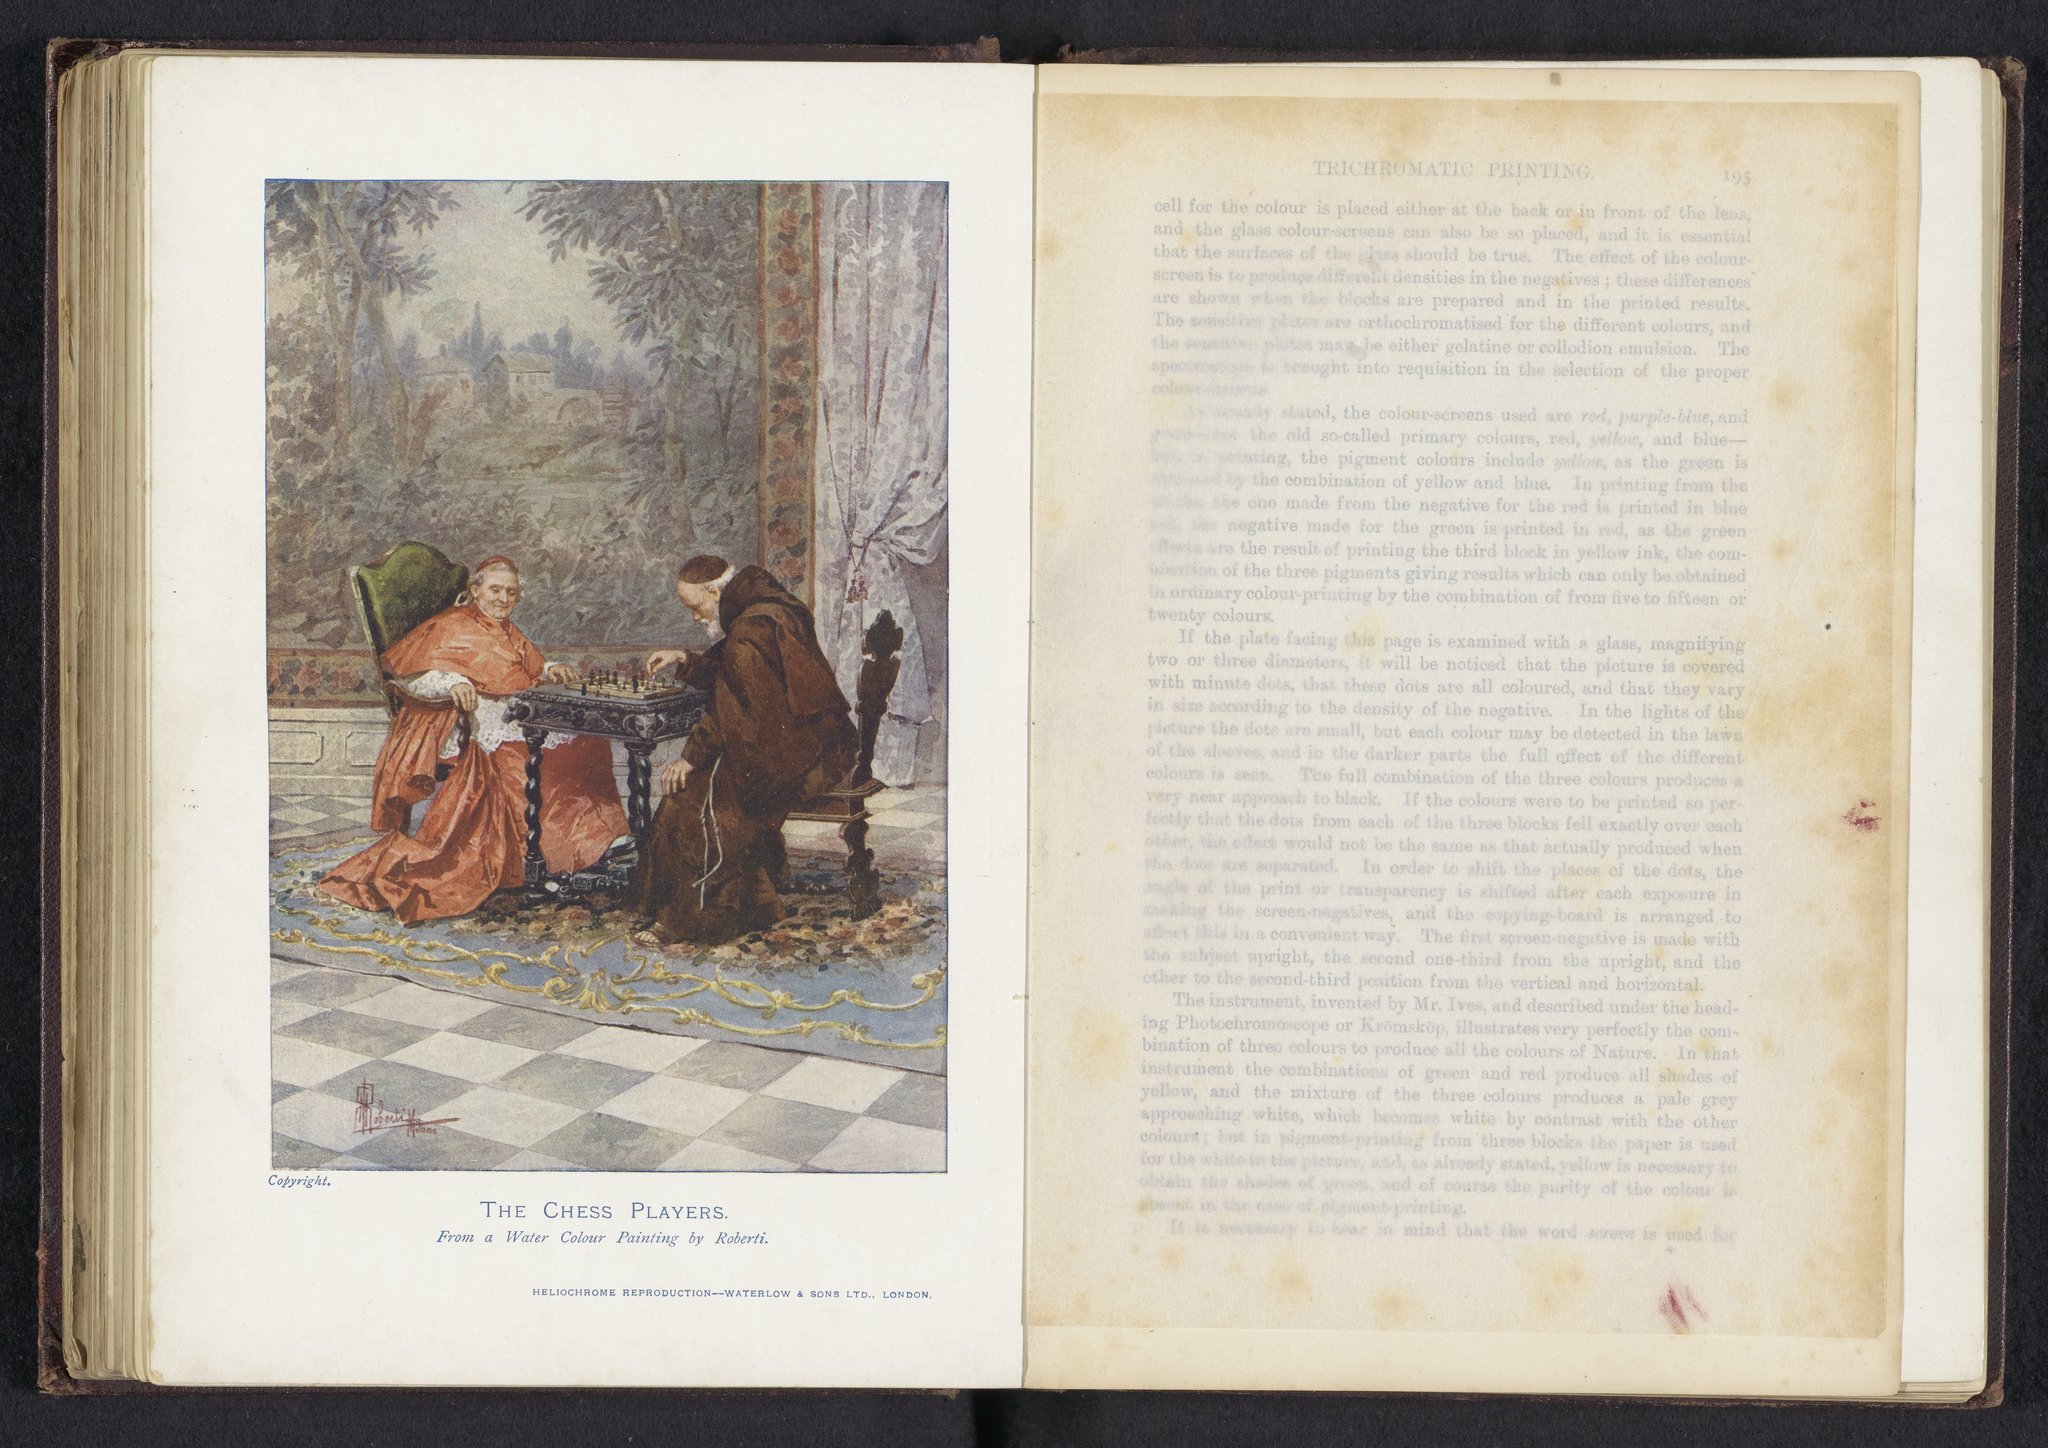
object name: page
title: The chess players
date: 1889-1899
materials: paper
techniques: color autotype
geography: london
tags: chess, exterior ~ representation of a building, organization, functionaries and dignitaries in roman catholic church; clergy in general